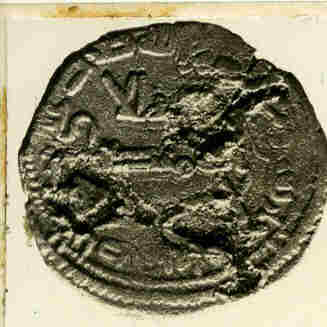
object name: coin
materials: copper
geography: iran